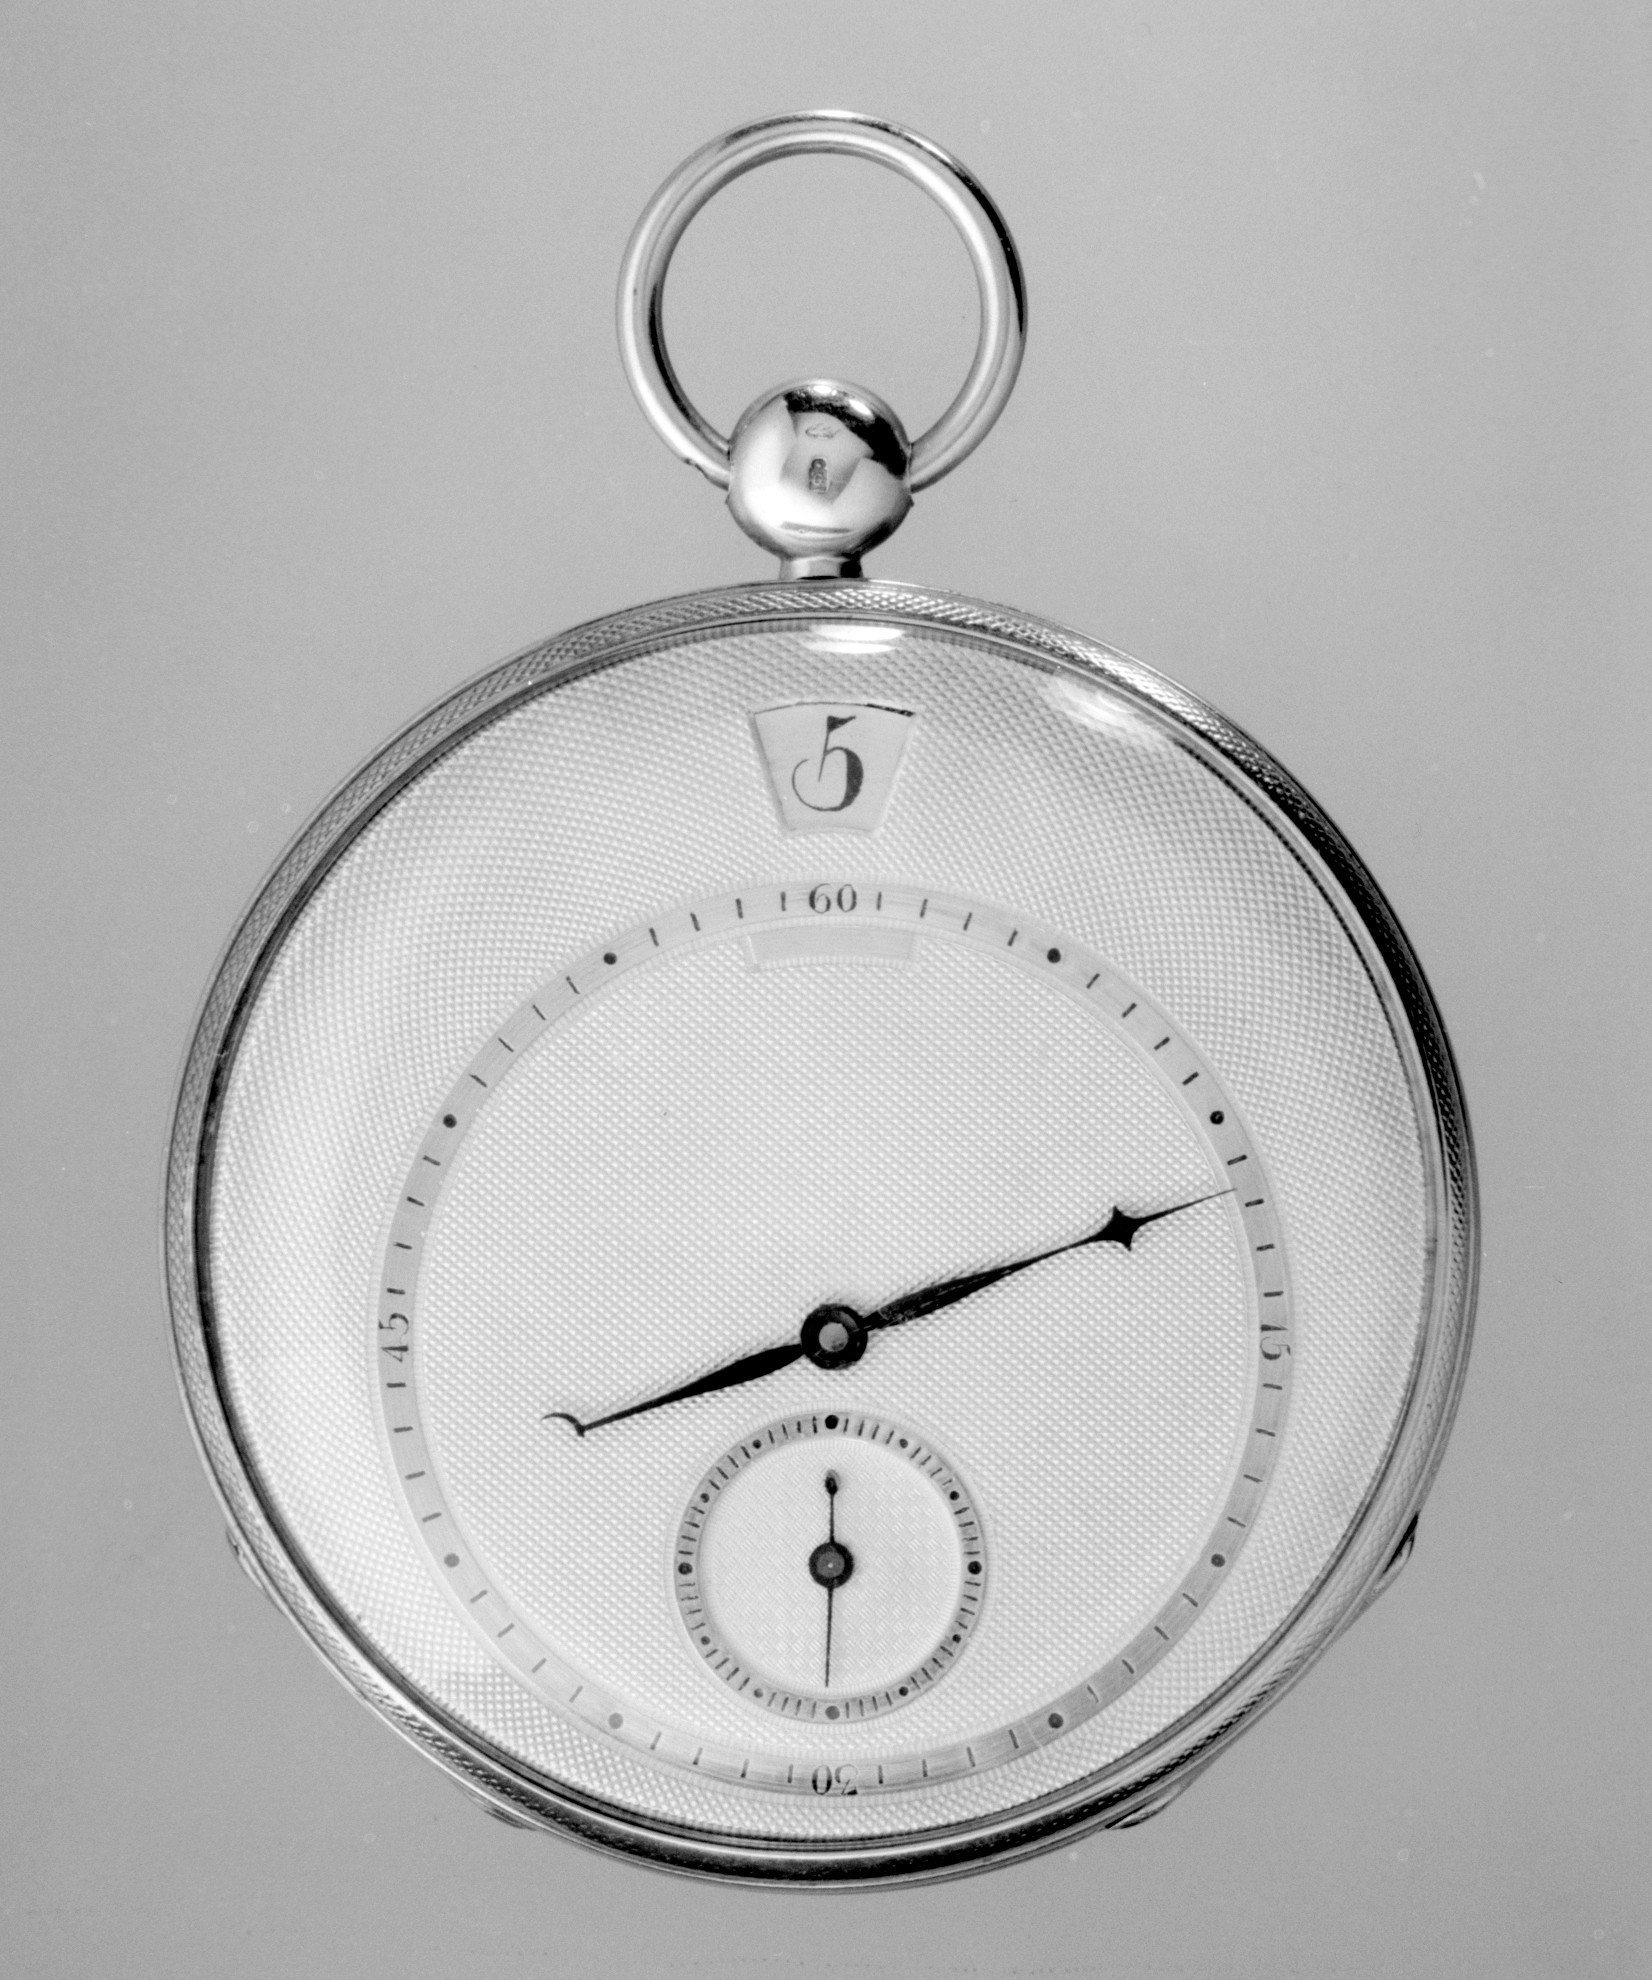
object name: watch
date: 1820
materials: gold, silver